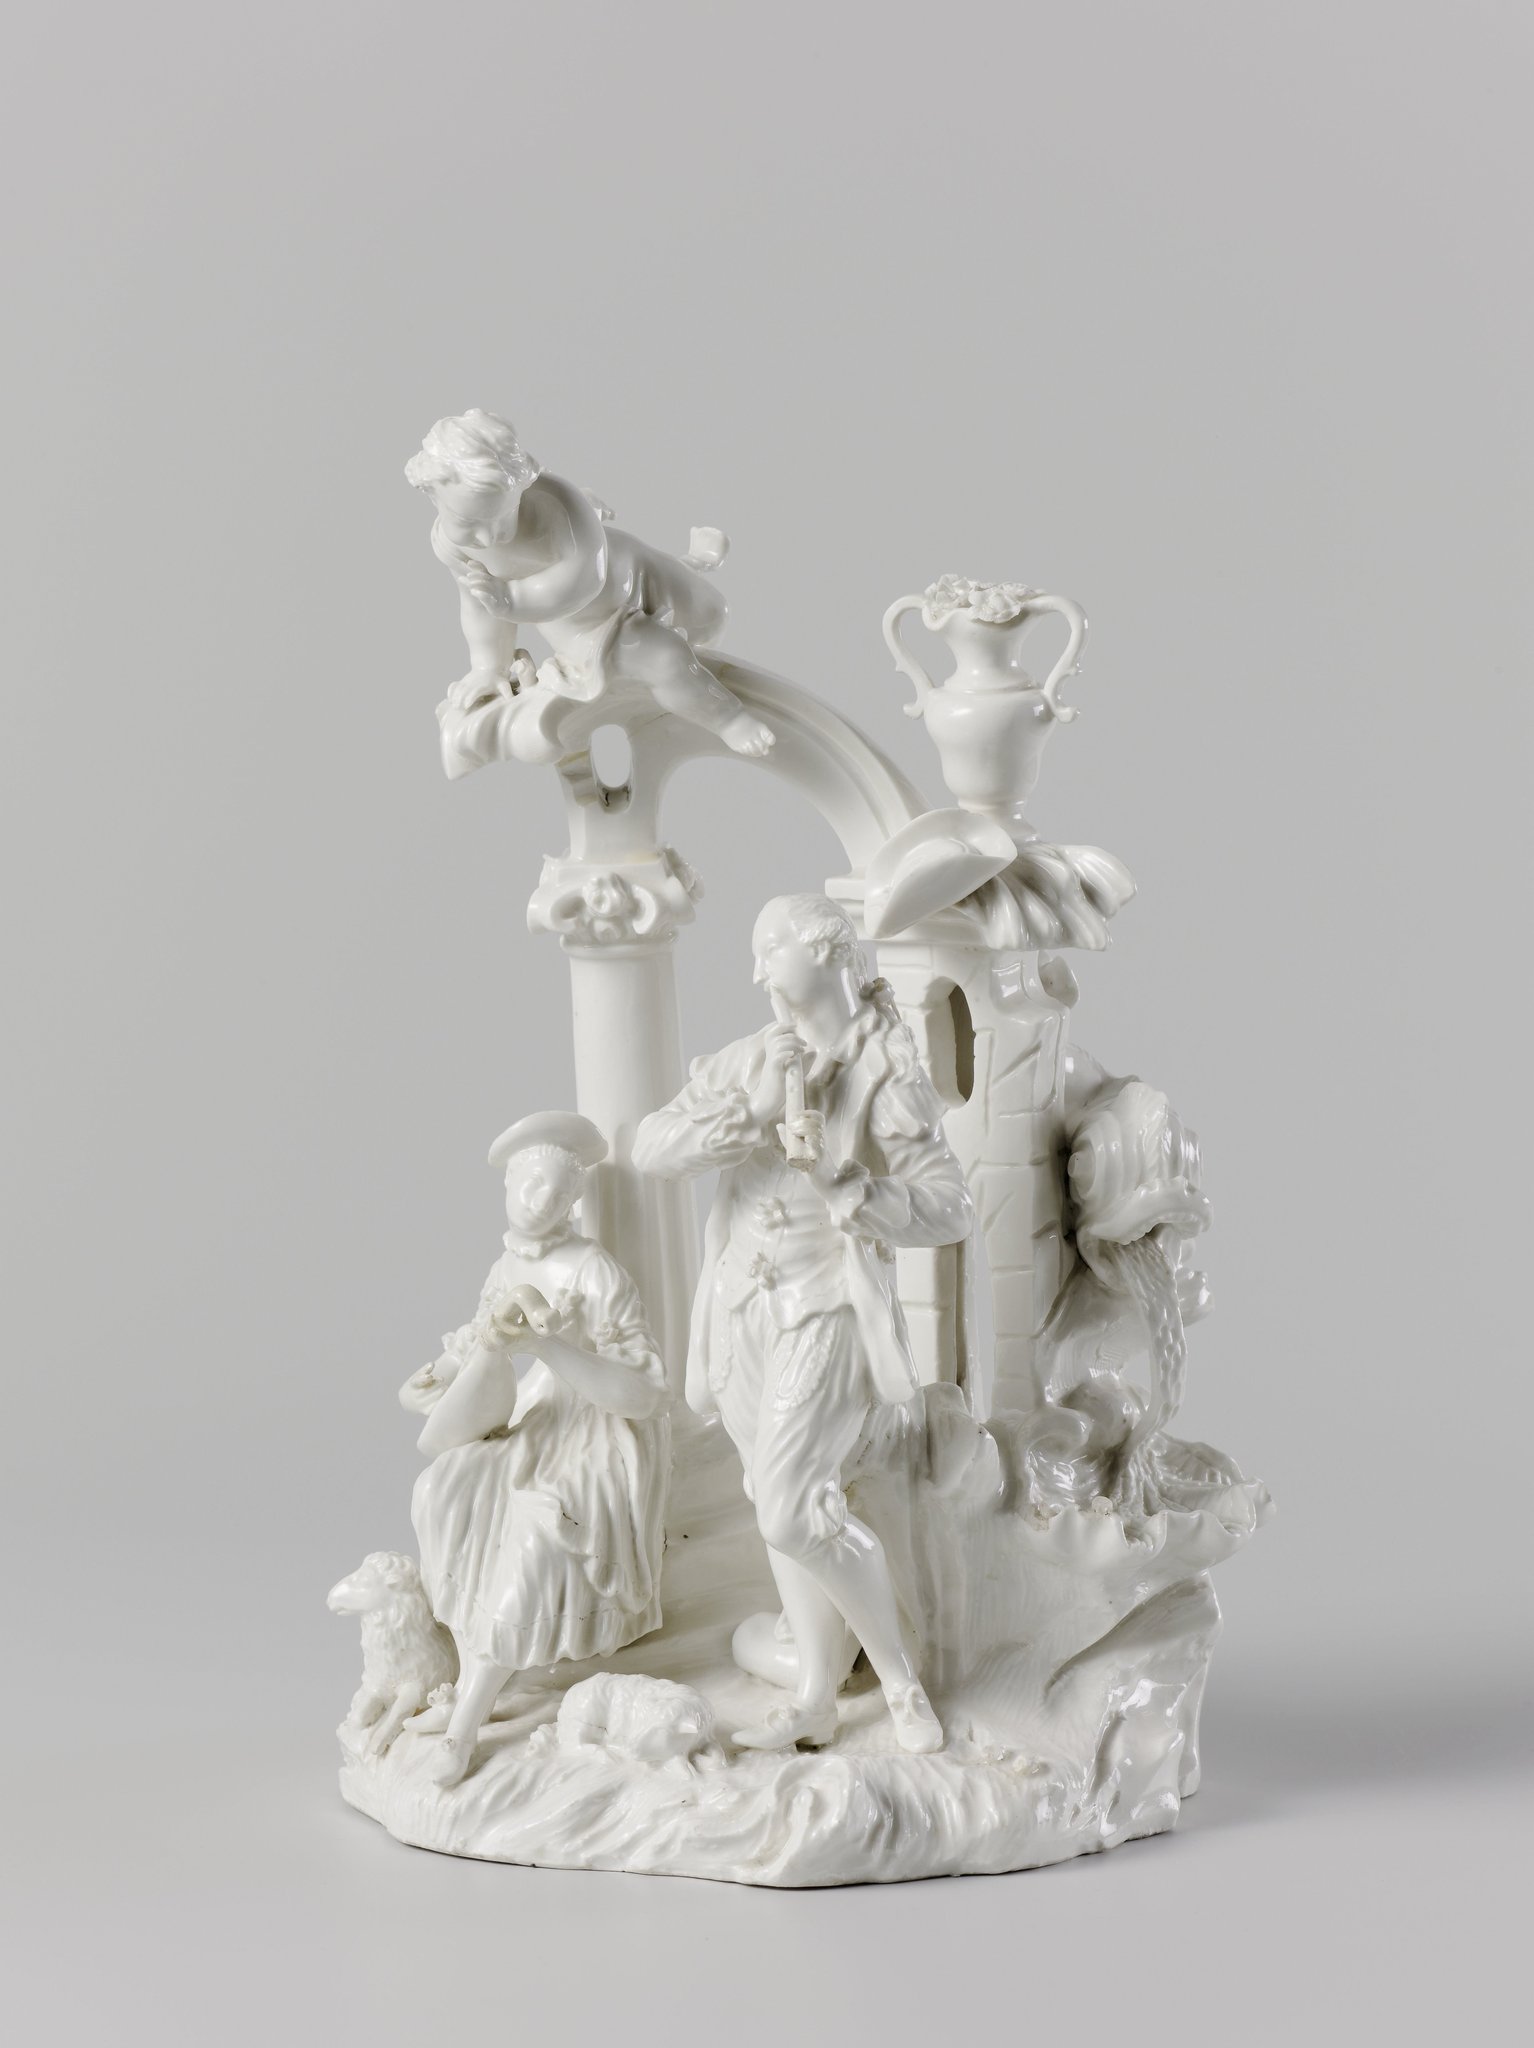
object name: sculpture group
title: Een herder en een herderin bij een ruïne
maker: nicolas-joseph gauron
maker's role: keramiekontwerper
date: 1764-1765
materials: porcelain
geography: weesp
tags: herding, herdsman, herdswoman, shepherd, shepherdess, cowherd, etc., transverse flute, lute, and special forms of lute, e.g.: theorbo, pastorals, arcadian scenes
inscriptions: mark: ‘K, I’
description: Group of a shepherdess playing a lute and a shepherd playing a flute in a landscape. Porcelain. Weesp, c. 1765 - 1770. Factory of Betram, Count Gronsveld- Diepenbrock, the model presumably by Nicolas François Gauron (active c. 1750 - 1770).